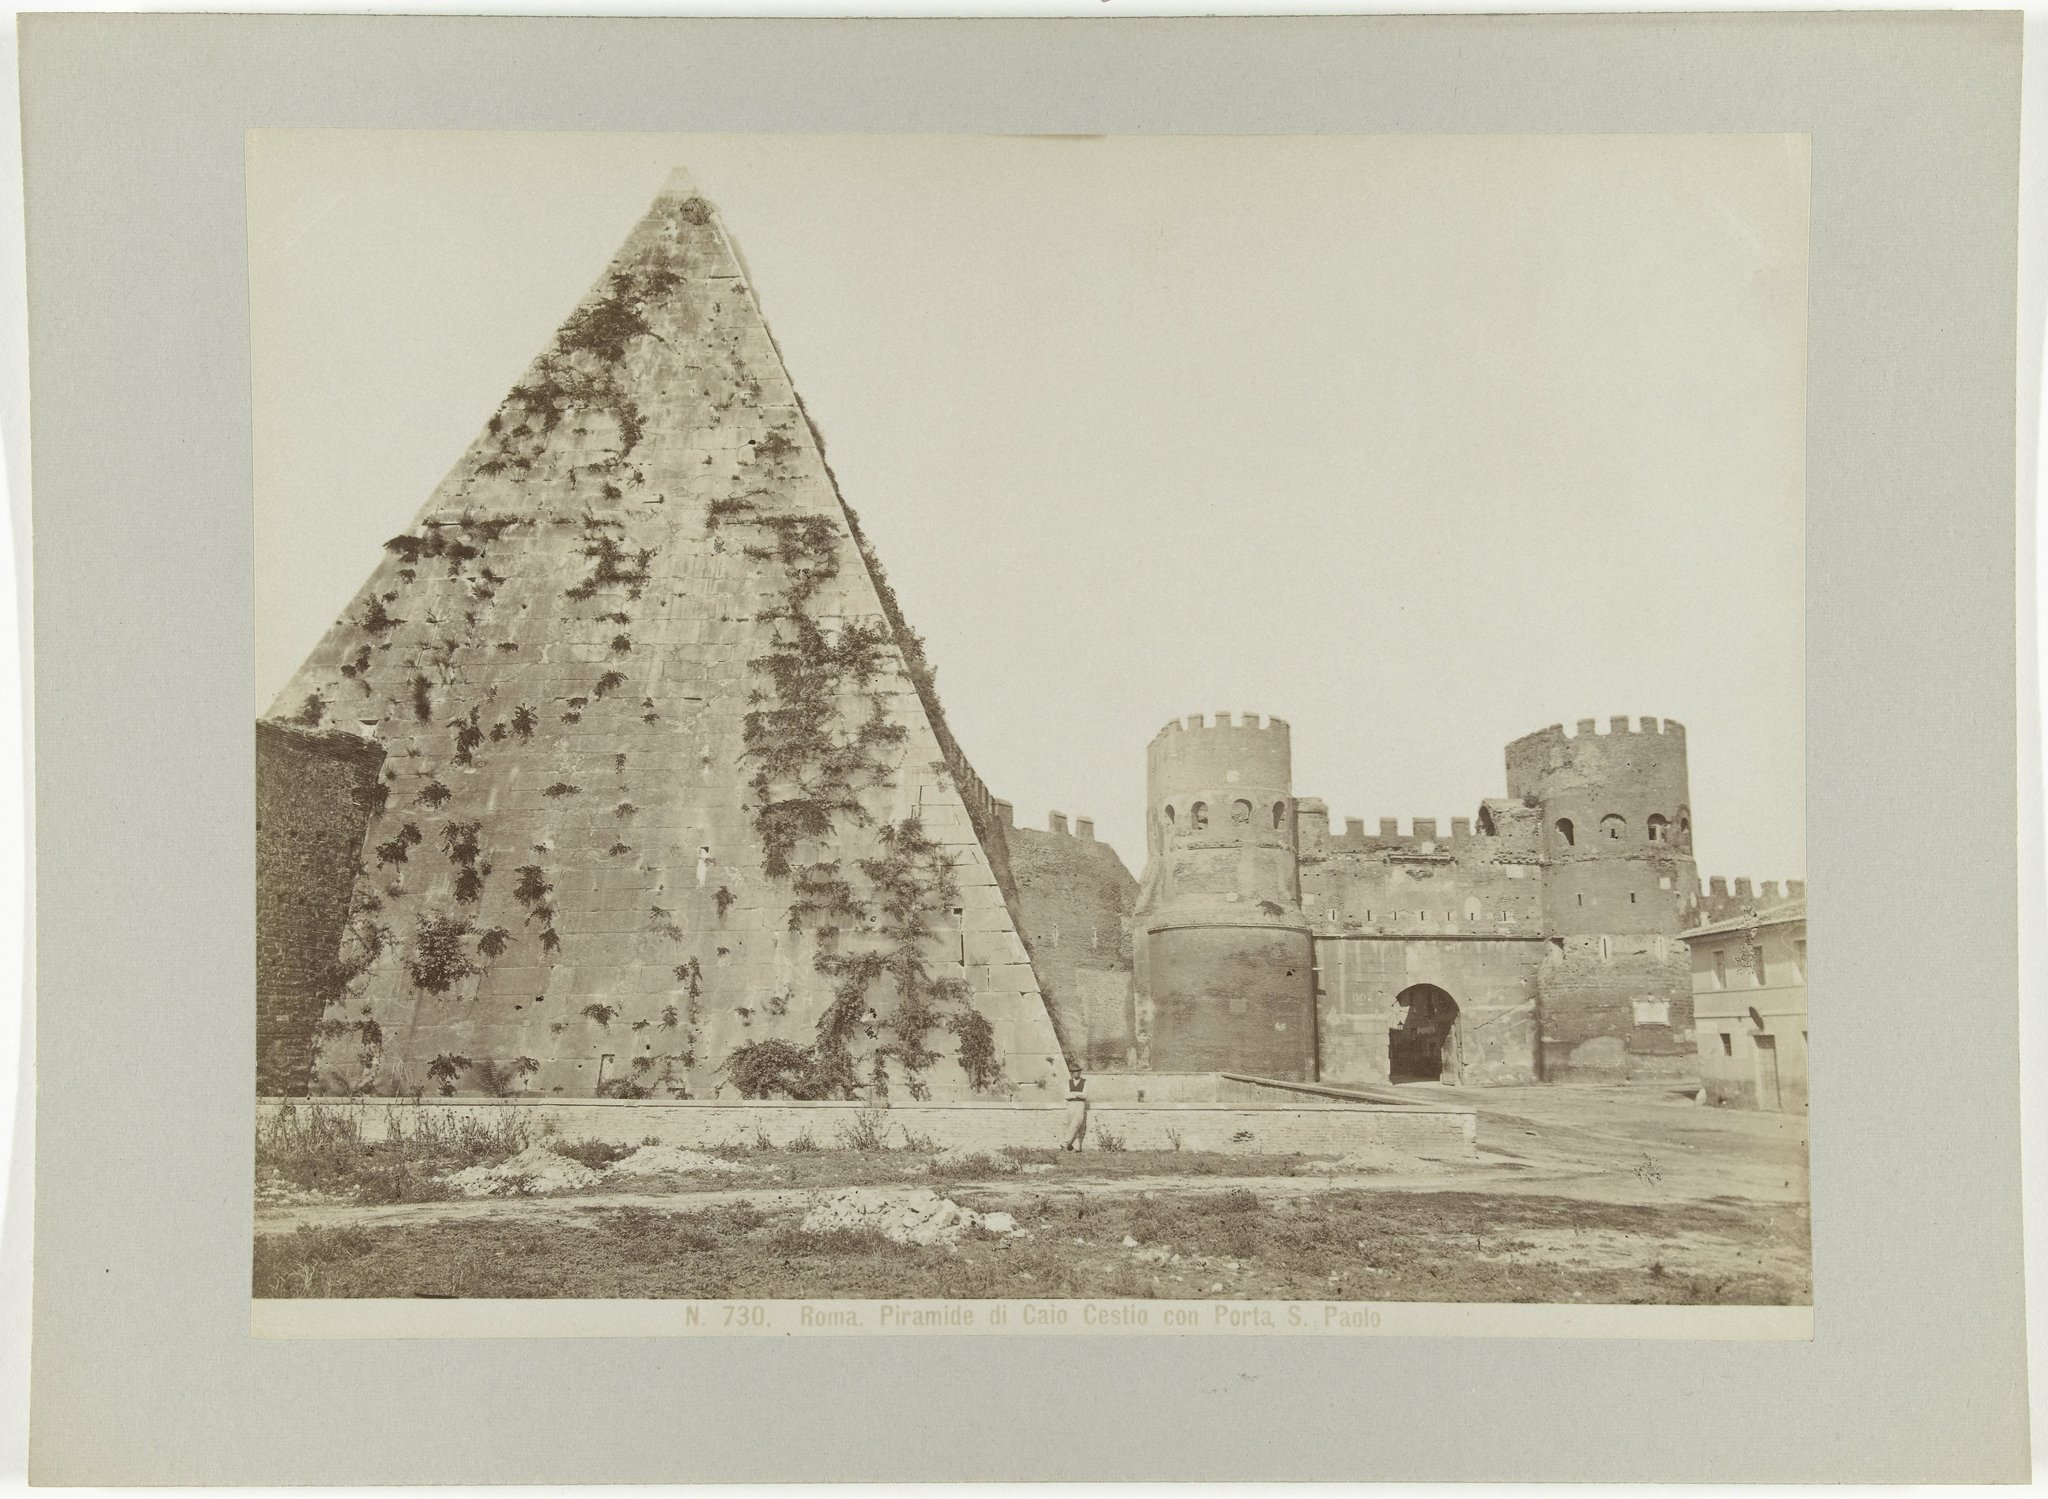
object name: photograph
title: Piramide van Gaius Cestius bij de Porta San Paolo, Rome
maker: Anonymous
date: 1880-1904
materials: cardboard, paper, photographic support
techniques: albumen print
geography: rome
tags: piramide van cestius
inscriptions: number: ‘27.’